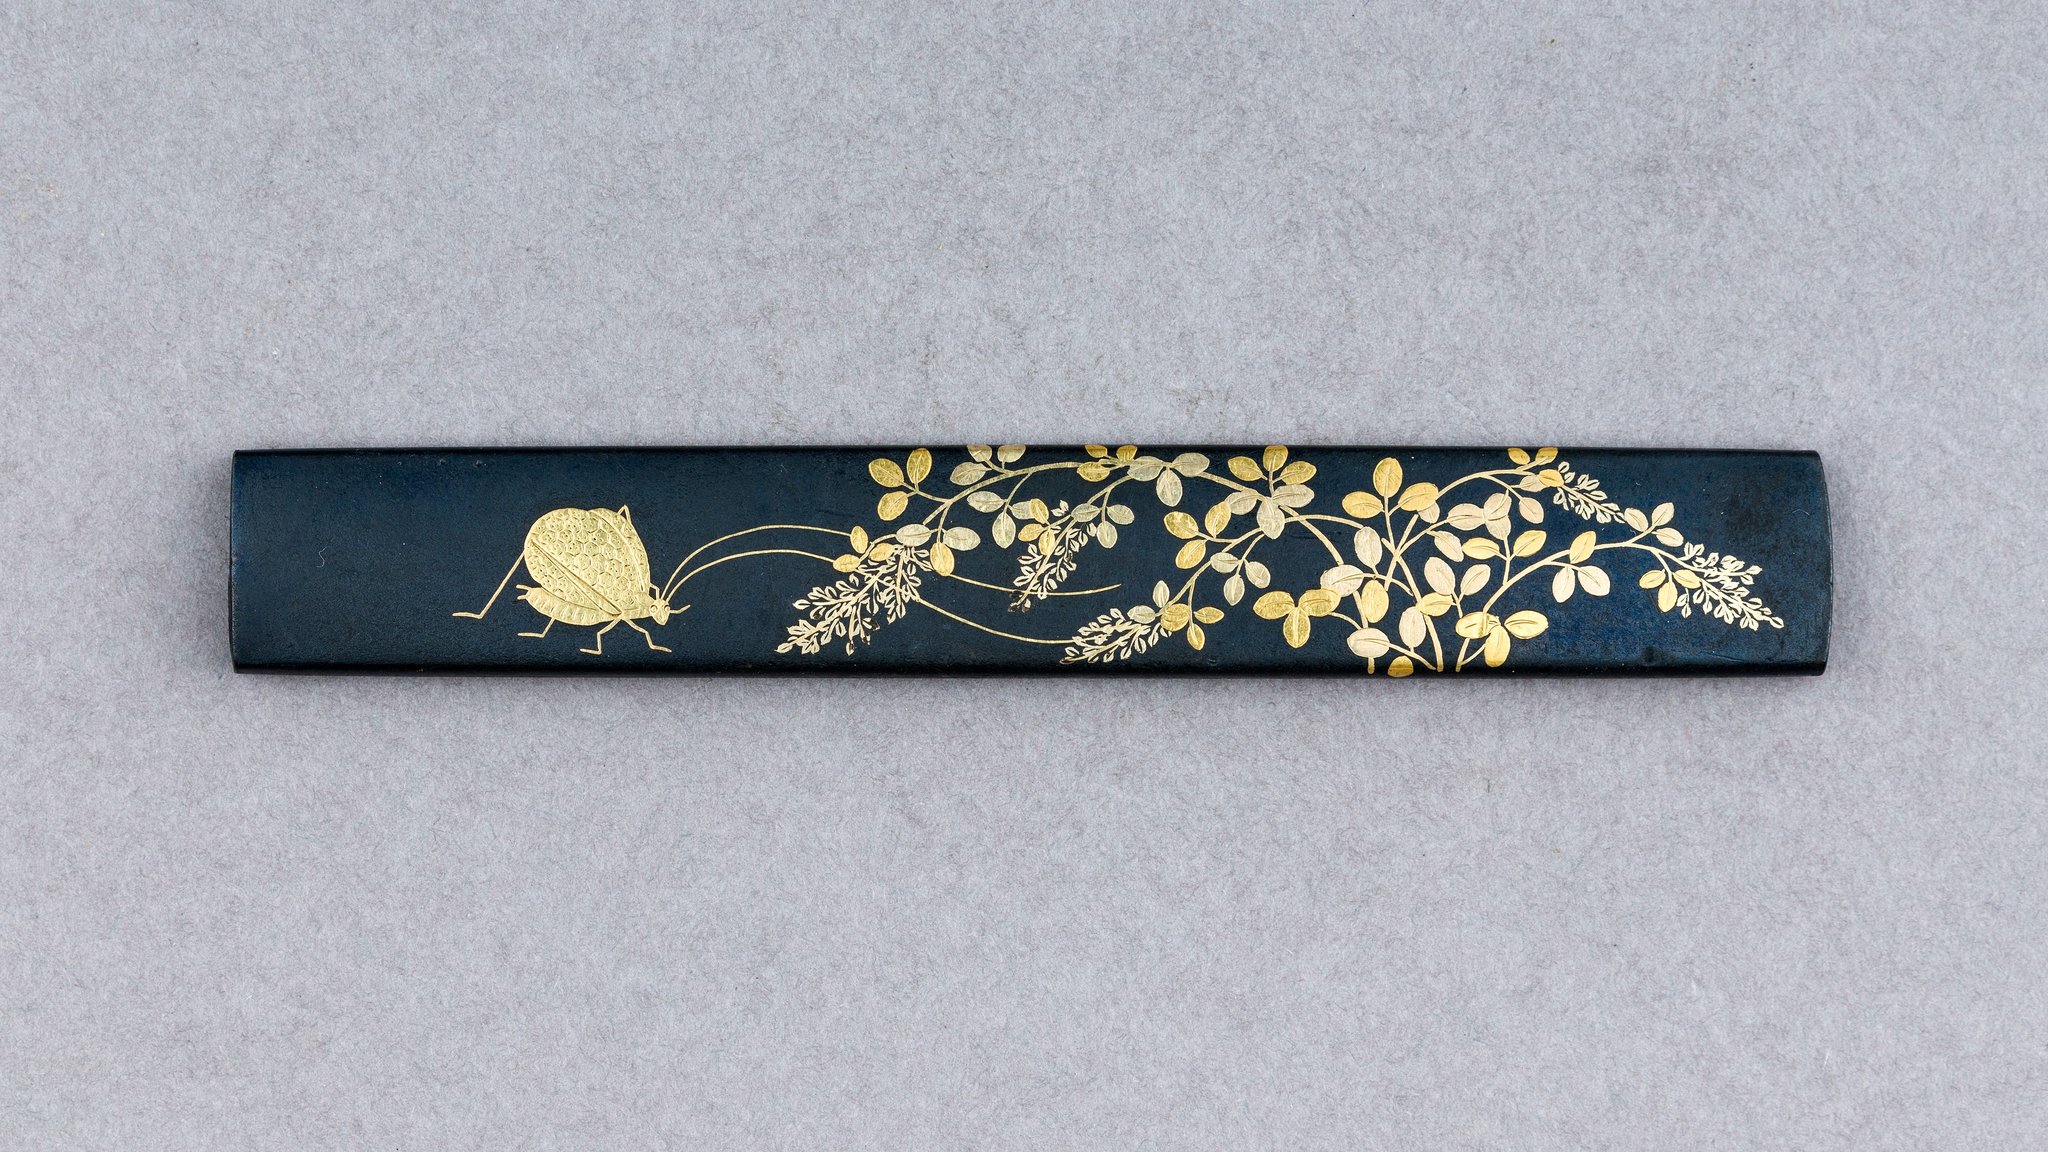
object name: knife handle kozuka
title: Knife Handle (Kozuka)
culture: japanese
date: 1615-1868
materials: gold alloy, silver alloy, gold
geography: japan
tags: insects,plants